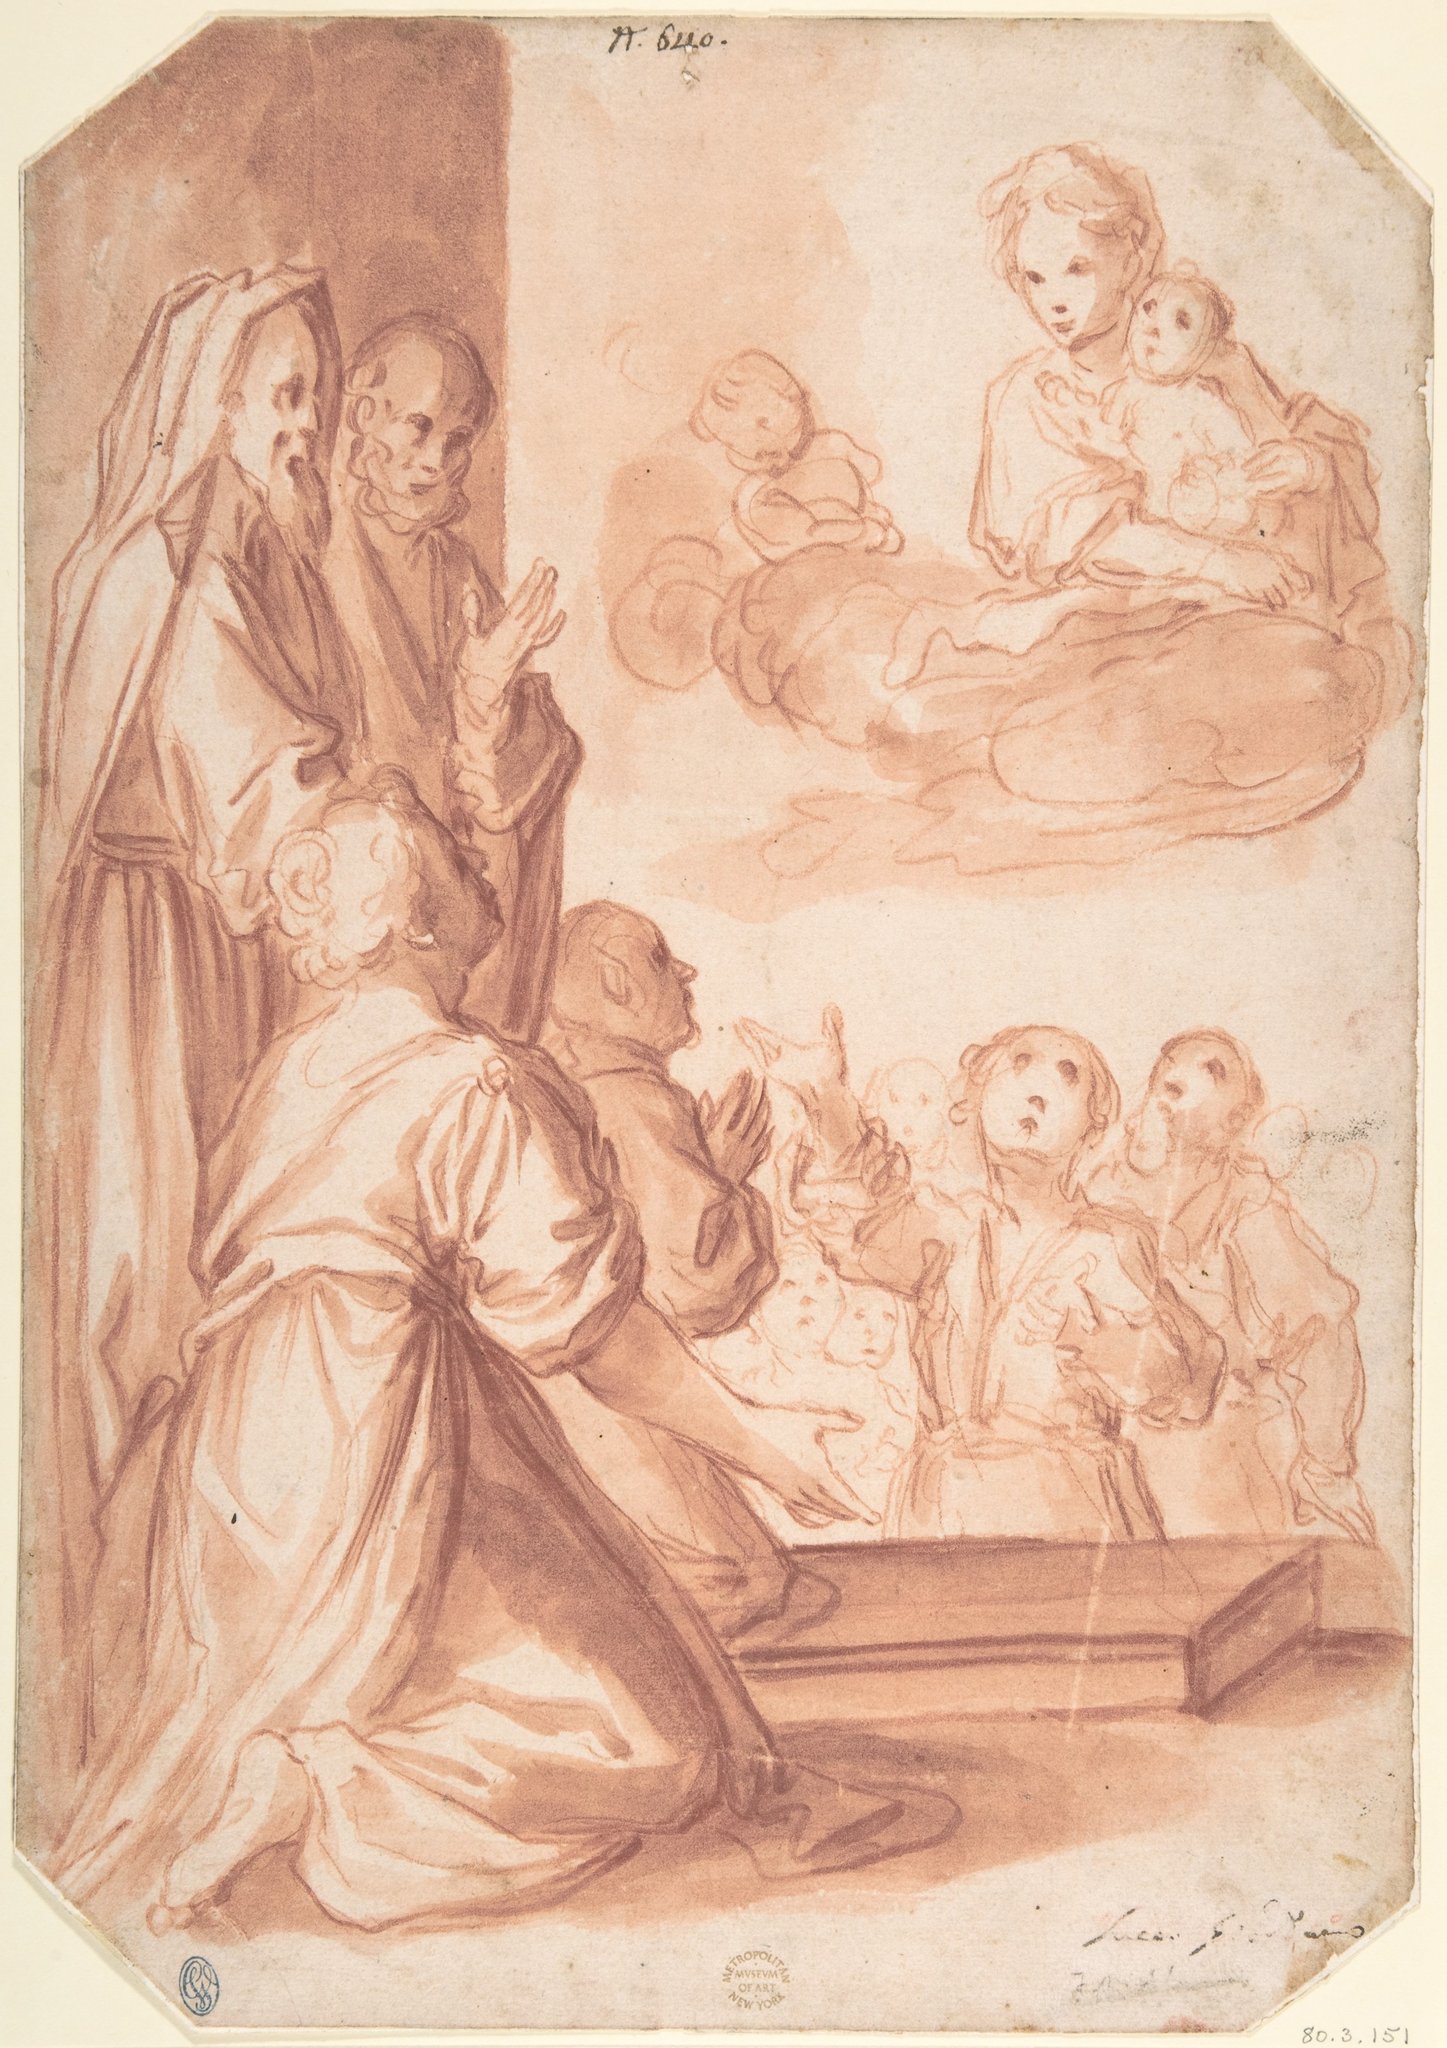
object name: drawing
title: Madonna and Child and Worshippers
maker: anonymous, italian, 16th to early 17th century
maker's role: artist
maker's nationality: italian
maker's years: 1500-1640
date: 1500-1640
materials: chalk, paper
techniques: brush, wash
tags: men,women,madonna and child,praying